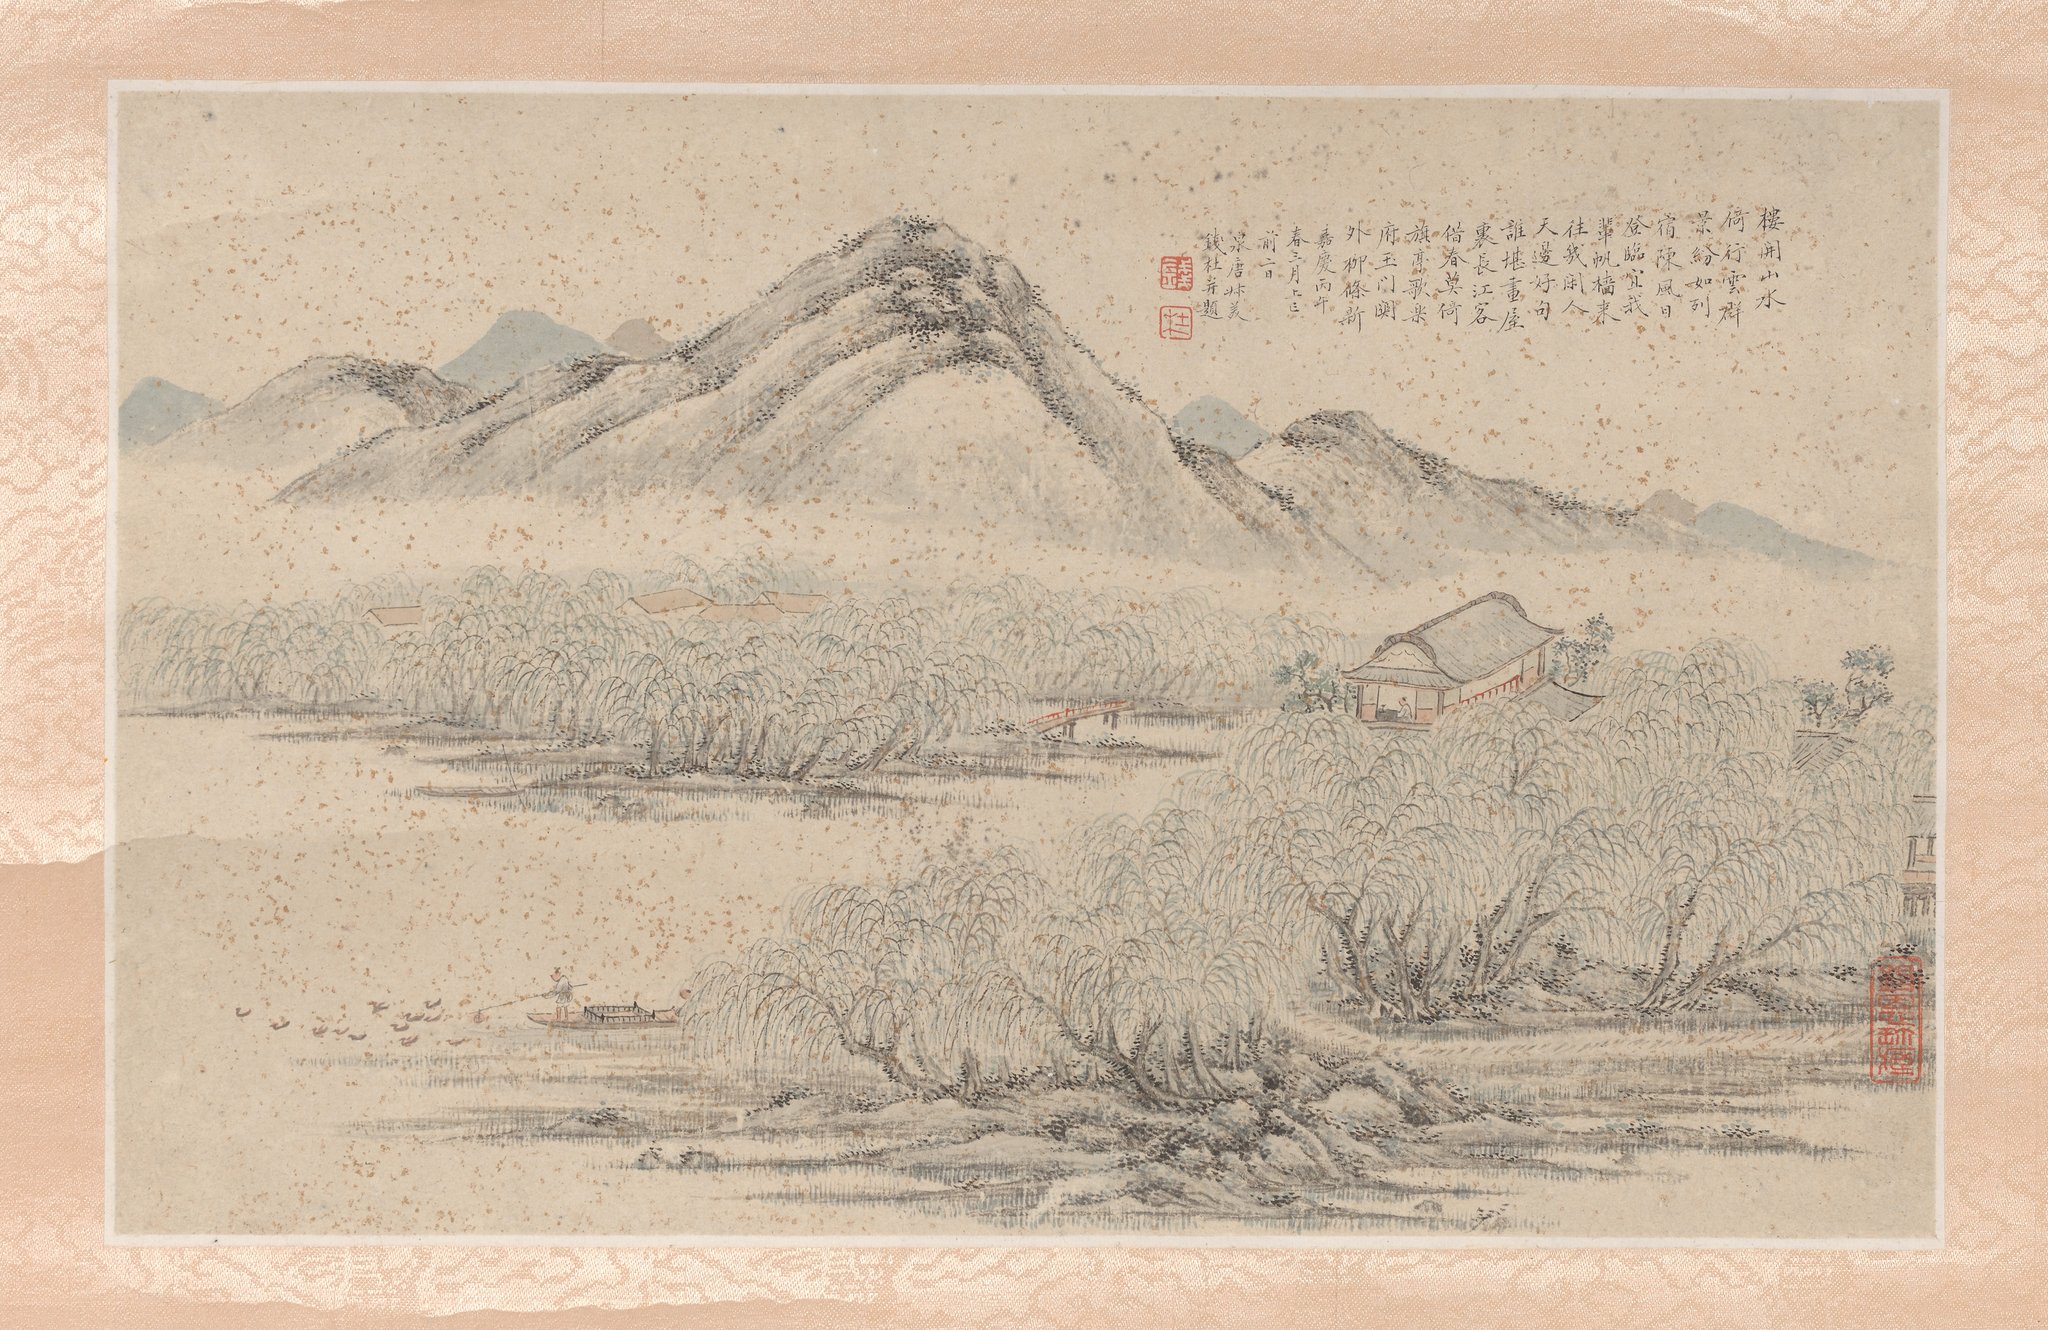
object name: mounted album leaf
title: Landscape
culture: chinese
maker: qian du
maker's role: artist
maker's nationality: chinese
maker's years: 1763-1844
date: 1786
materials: ink, paper